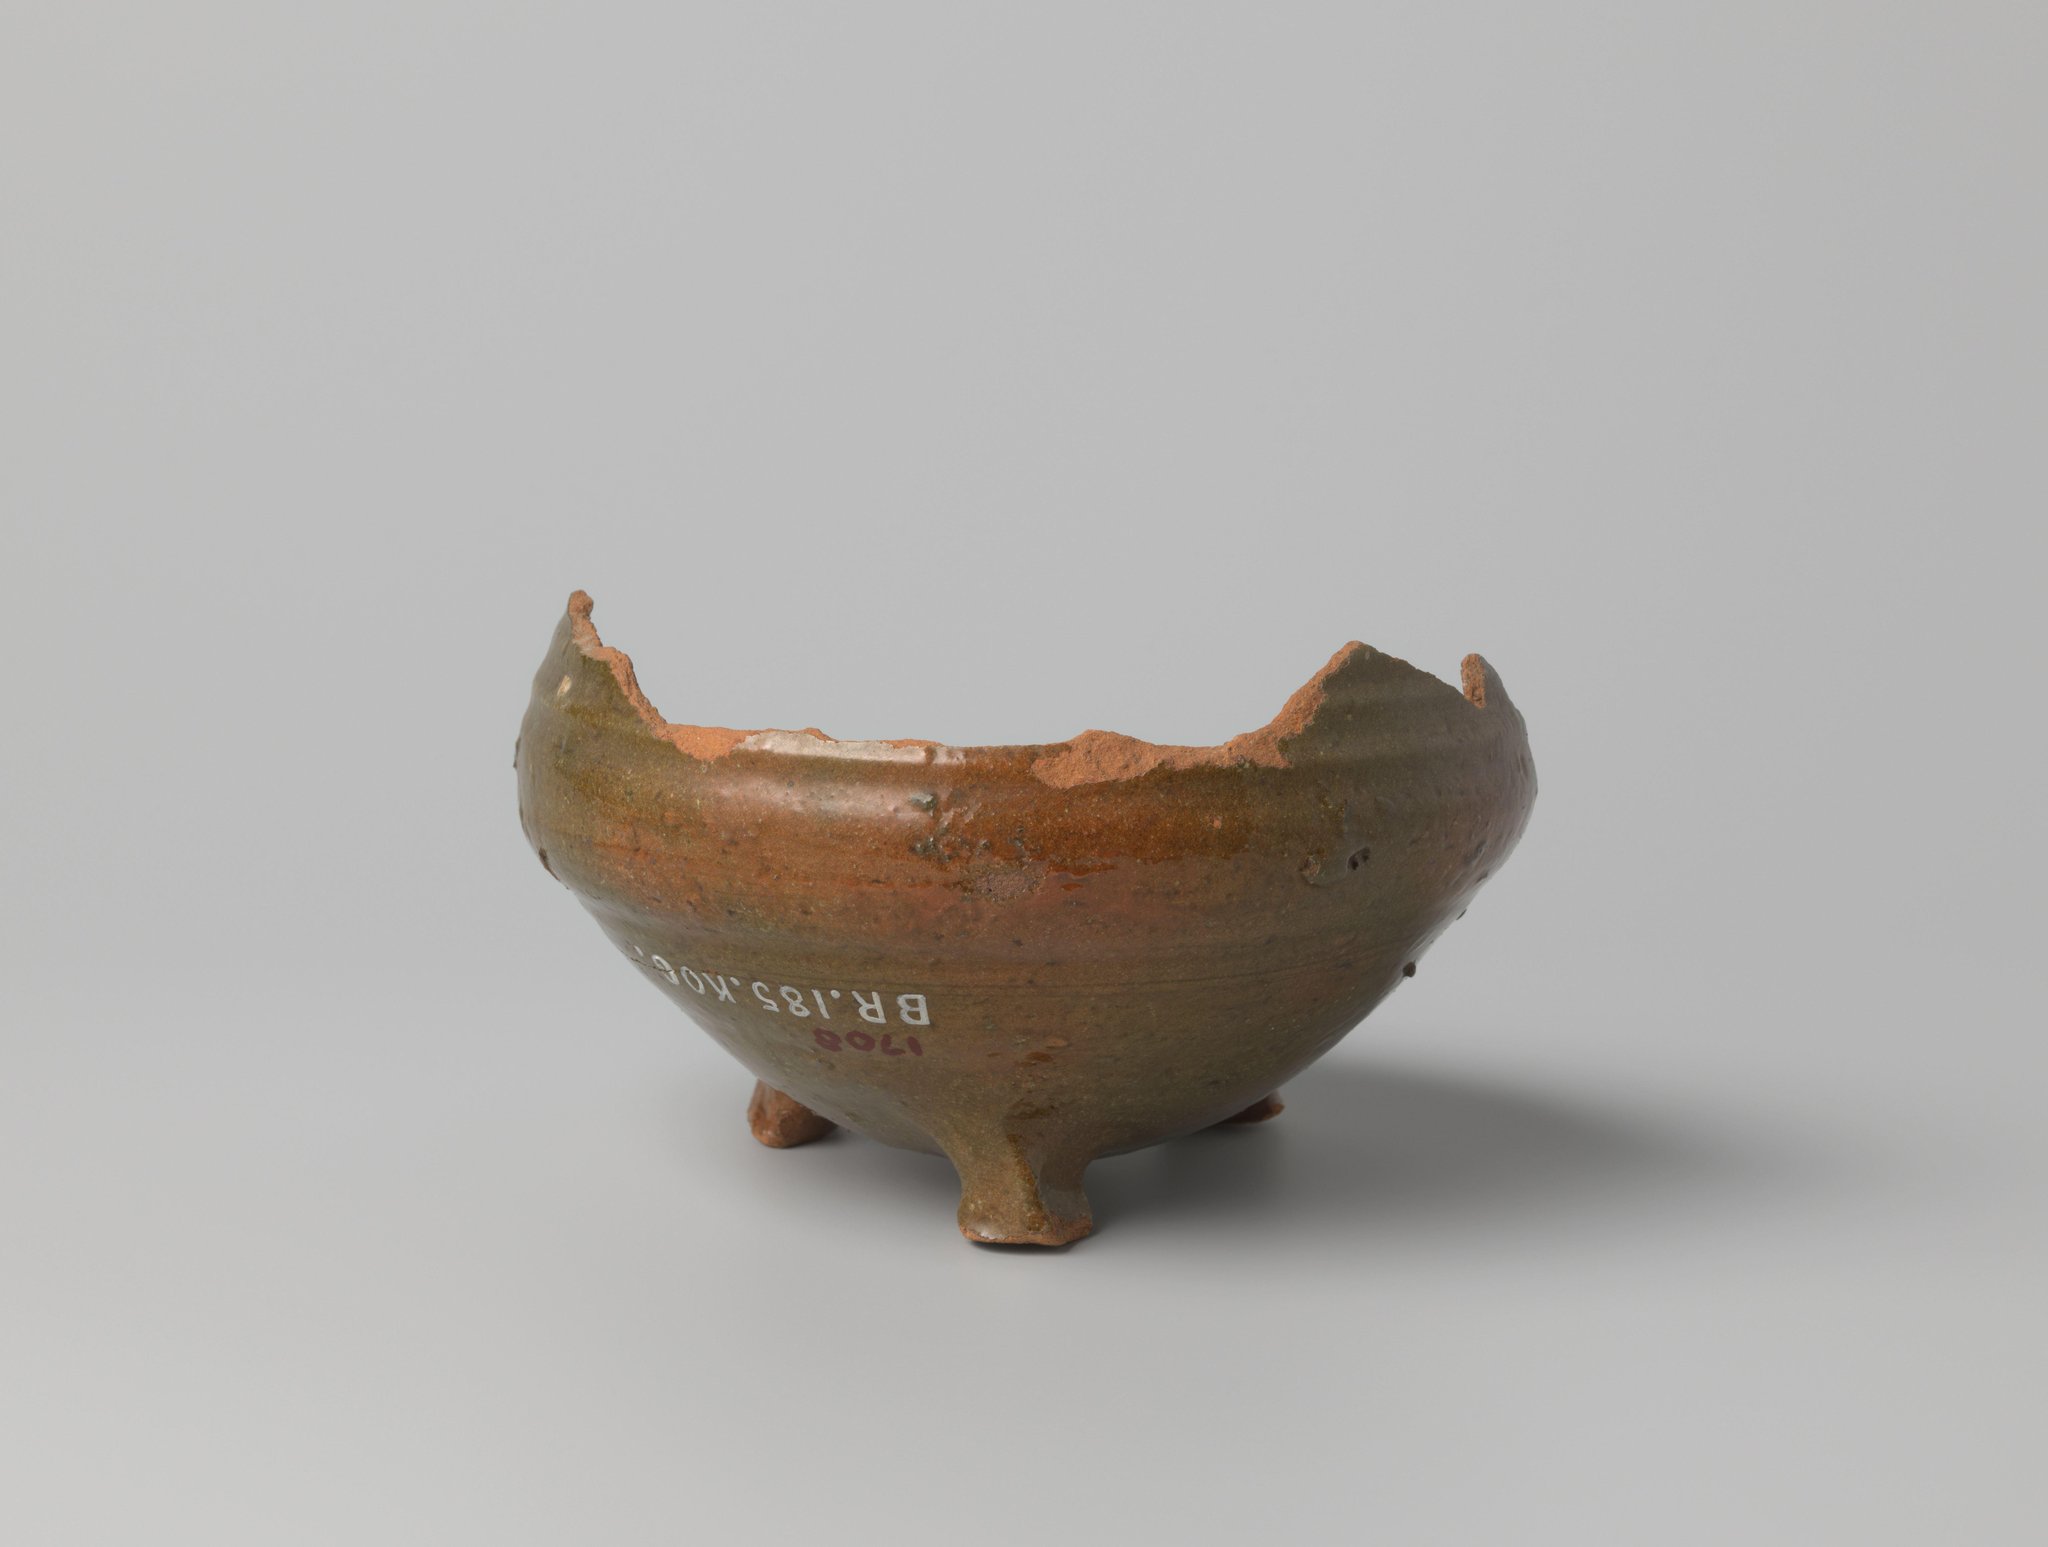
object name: pot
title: Pot van roodbakkende klei, van binnen en buiten voorzien van kleurloos loodglazuur, beschadigd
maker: Anonymous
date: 1500-1799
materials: earthenware, glaze